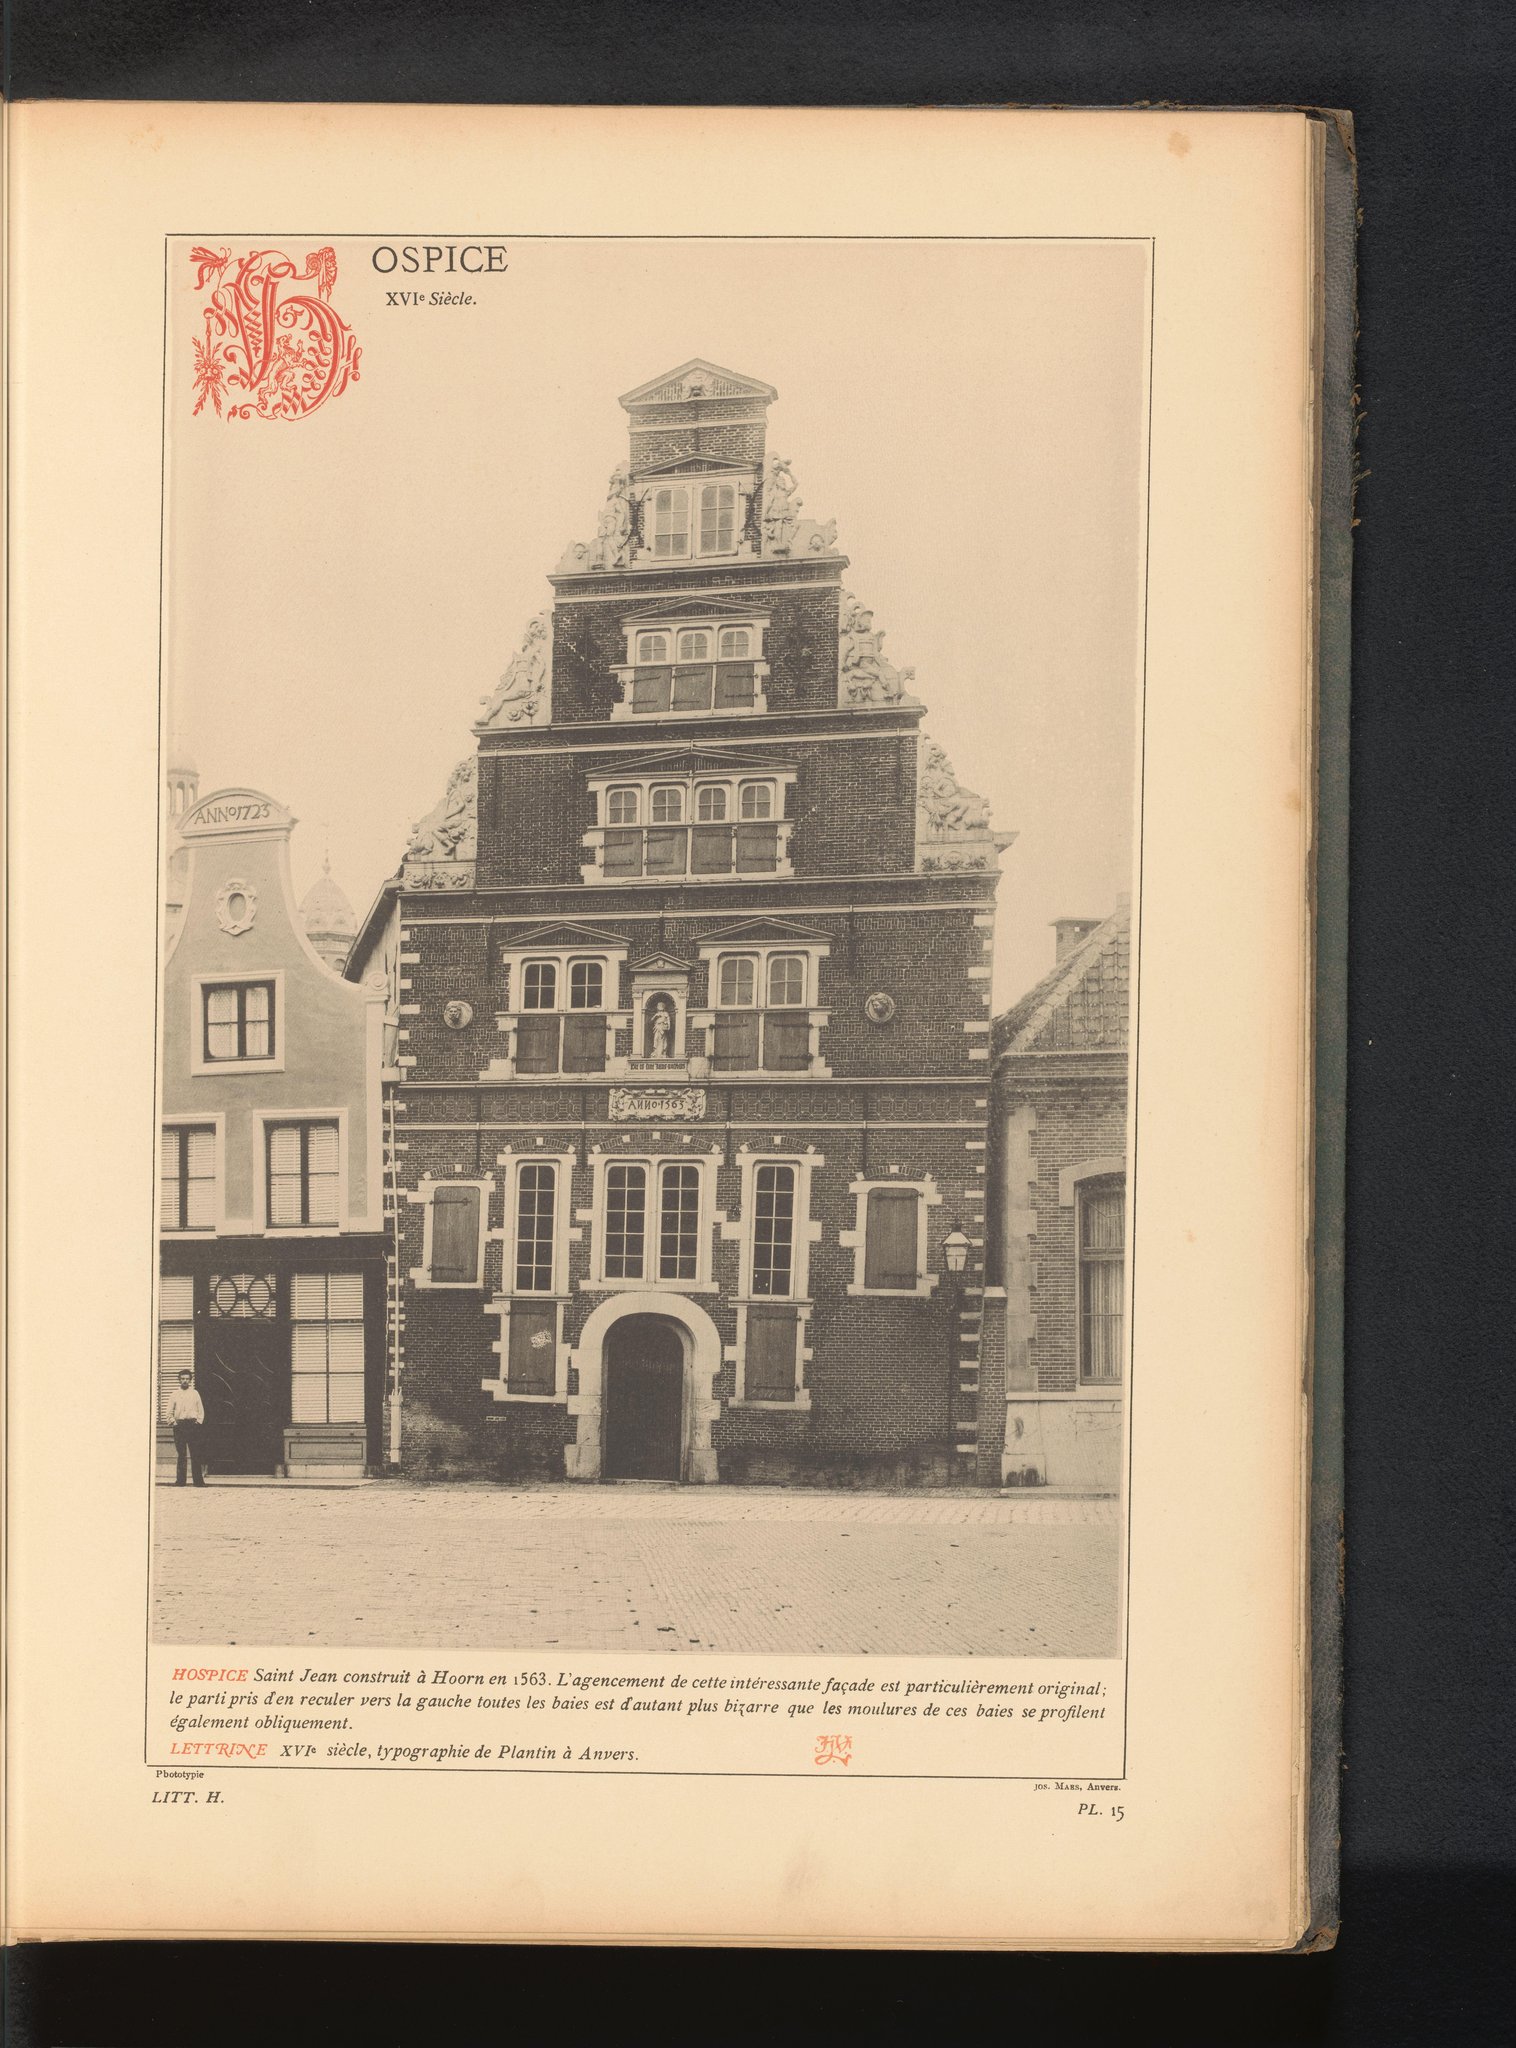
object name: page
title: Gezicht op het Sint Jansgasthuis in Hoorn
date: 1875-1880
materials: paper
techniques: photograph, photolithography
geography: hoorn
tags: civic architecture; edifices; dwellings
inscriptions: inscription: ‘HOSPICE Saint Jean (...)’, inscription: ‘LITT. H. - PL. 15’, monogram: ‘JJvY’